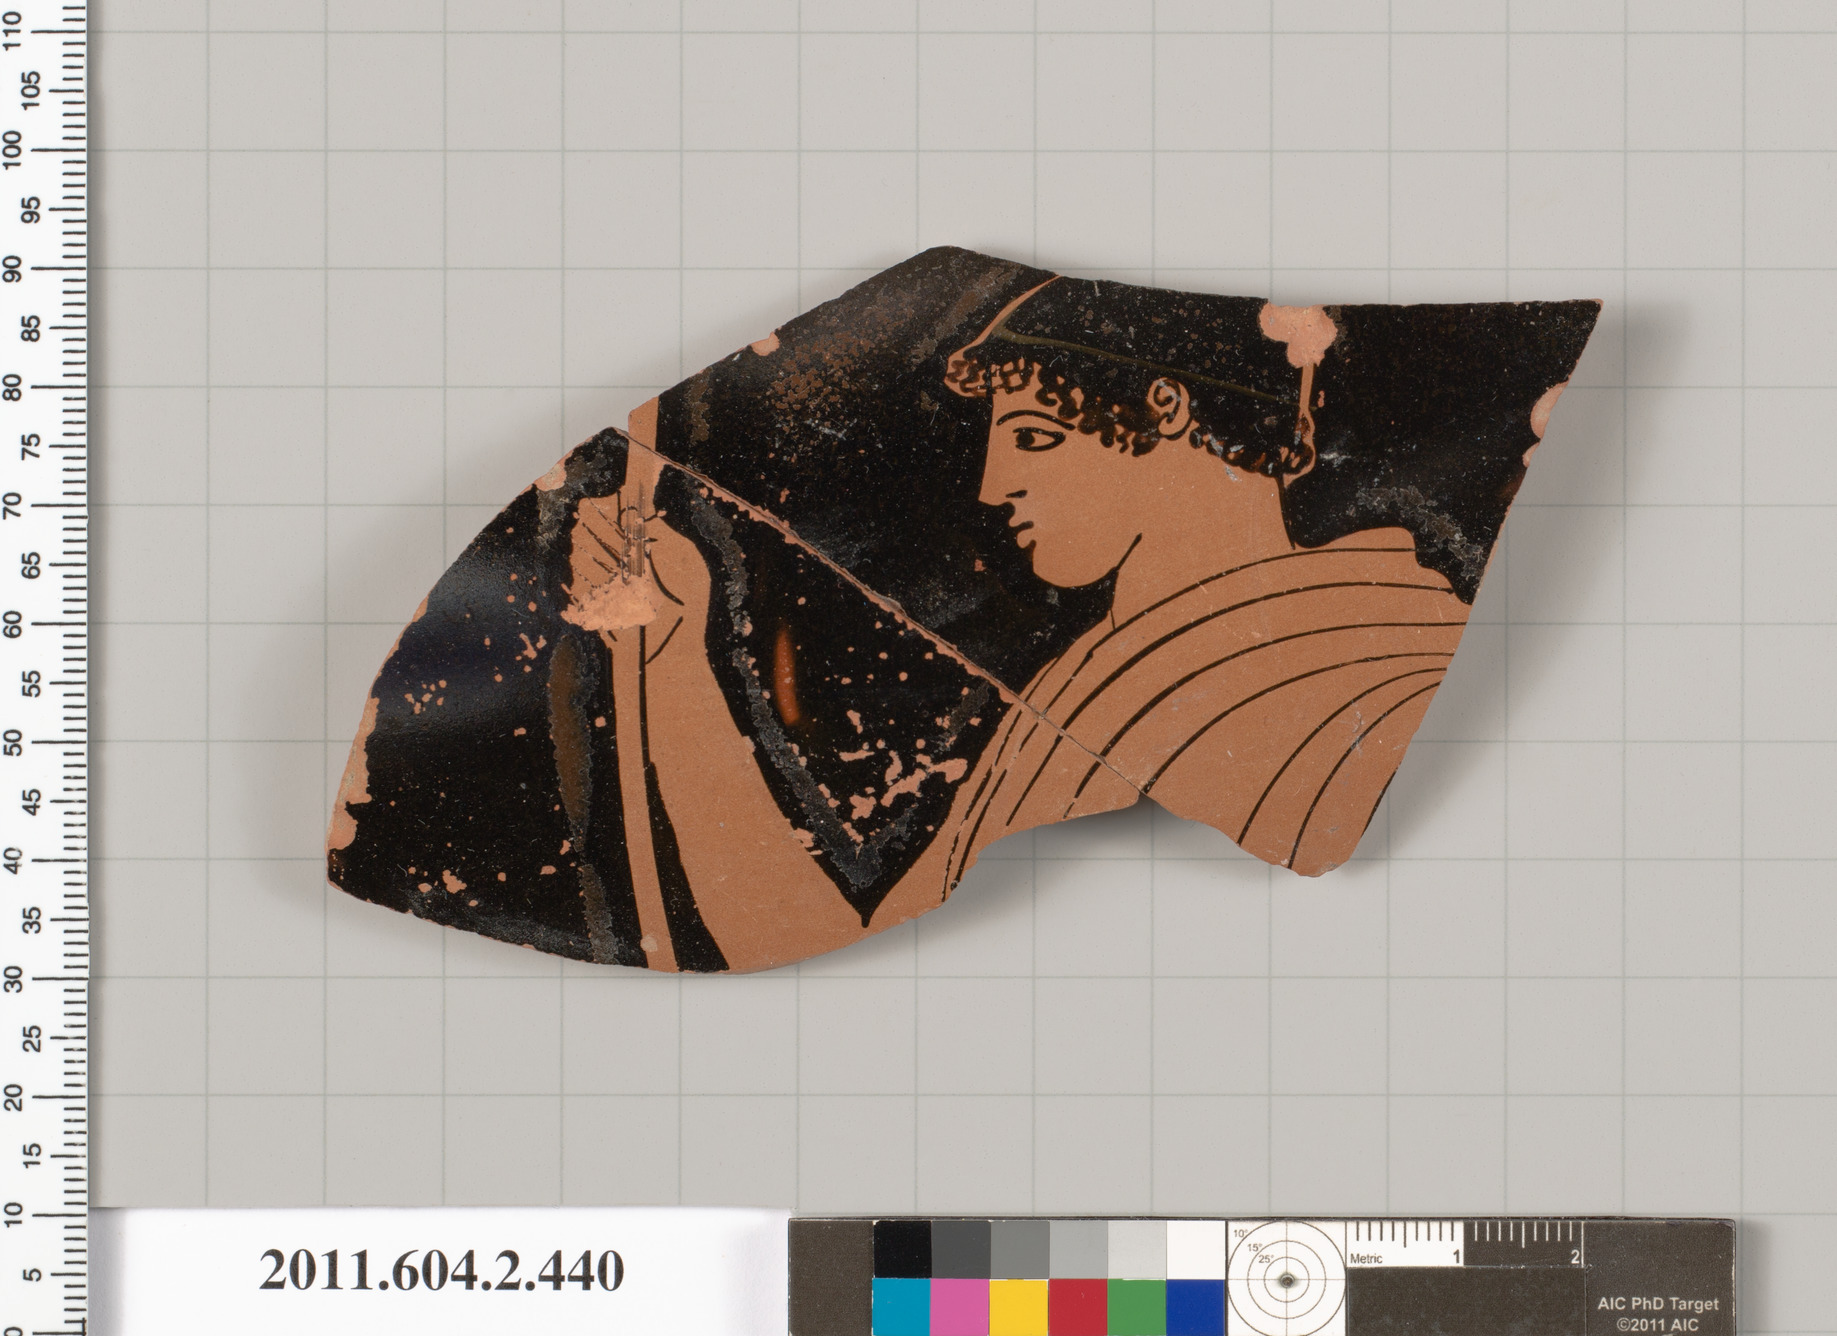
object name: column krater fragment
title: Terracotta fragment of a column-krater (bowl for mixing wine and water)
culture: greek, attic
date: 475-451 BCE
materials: terracotta